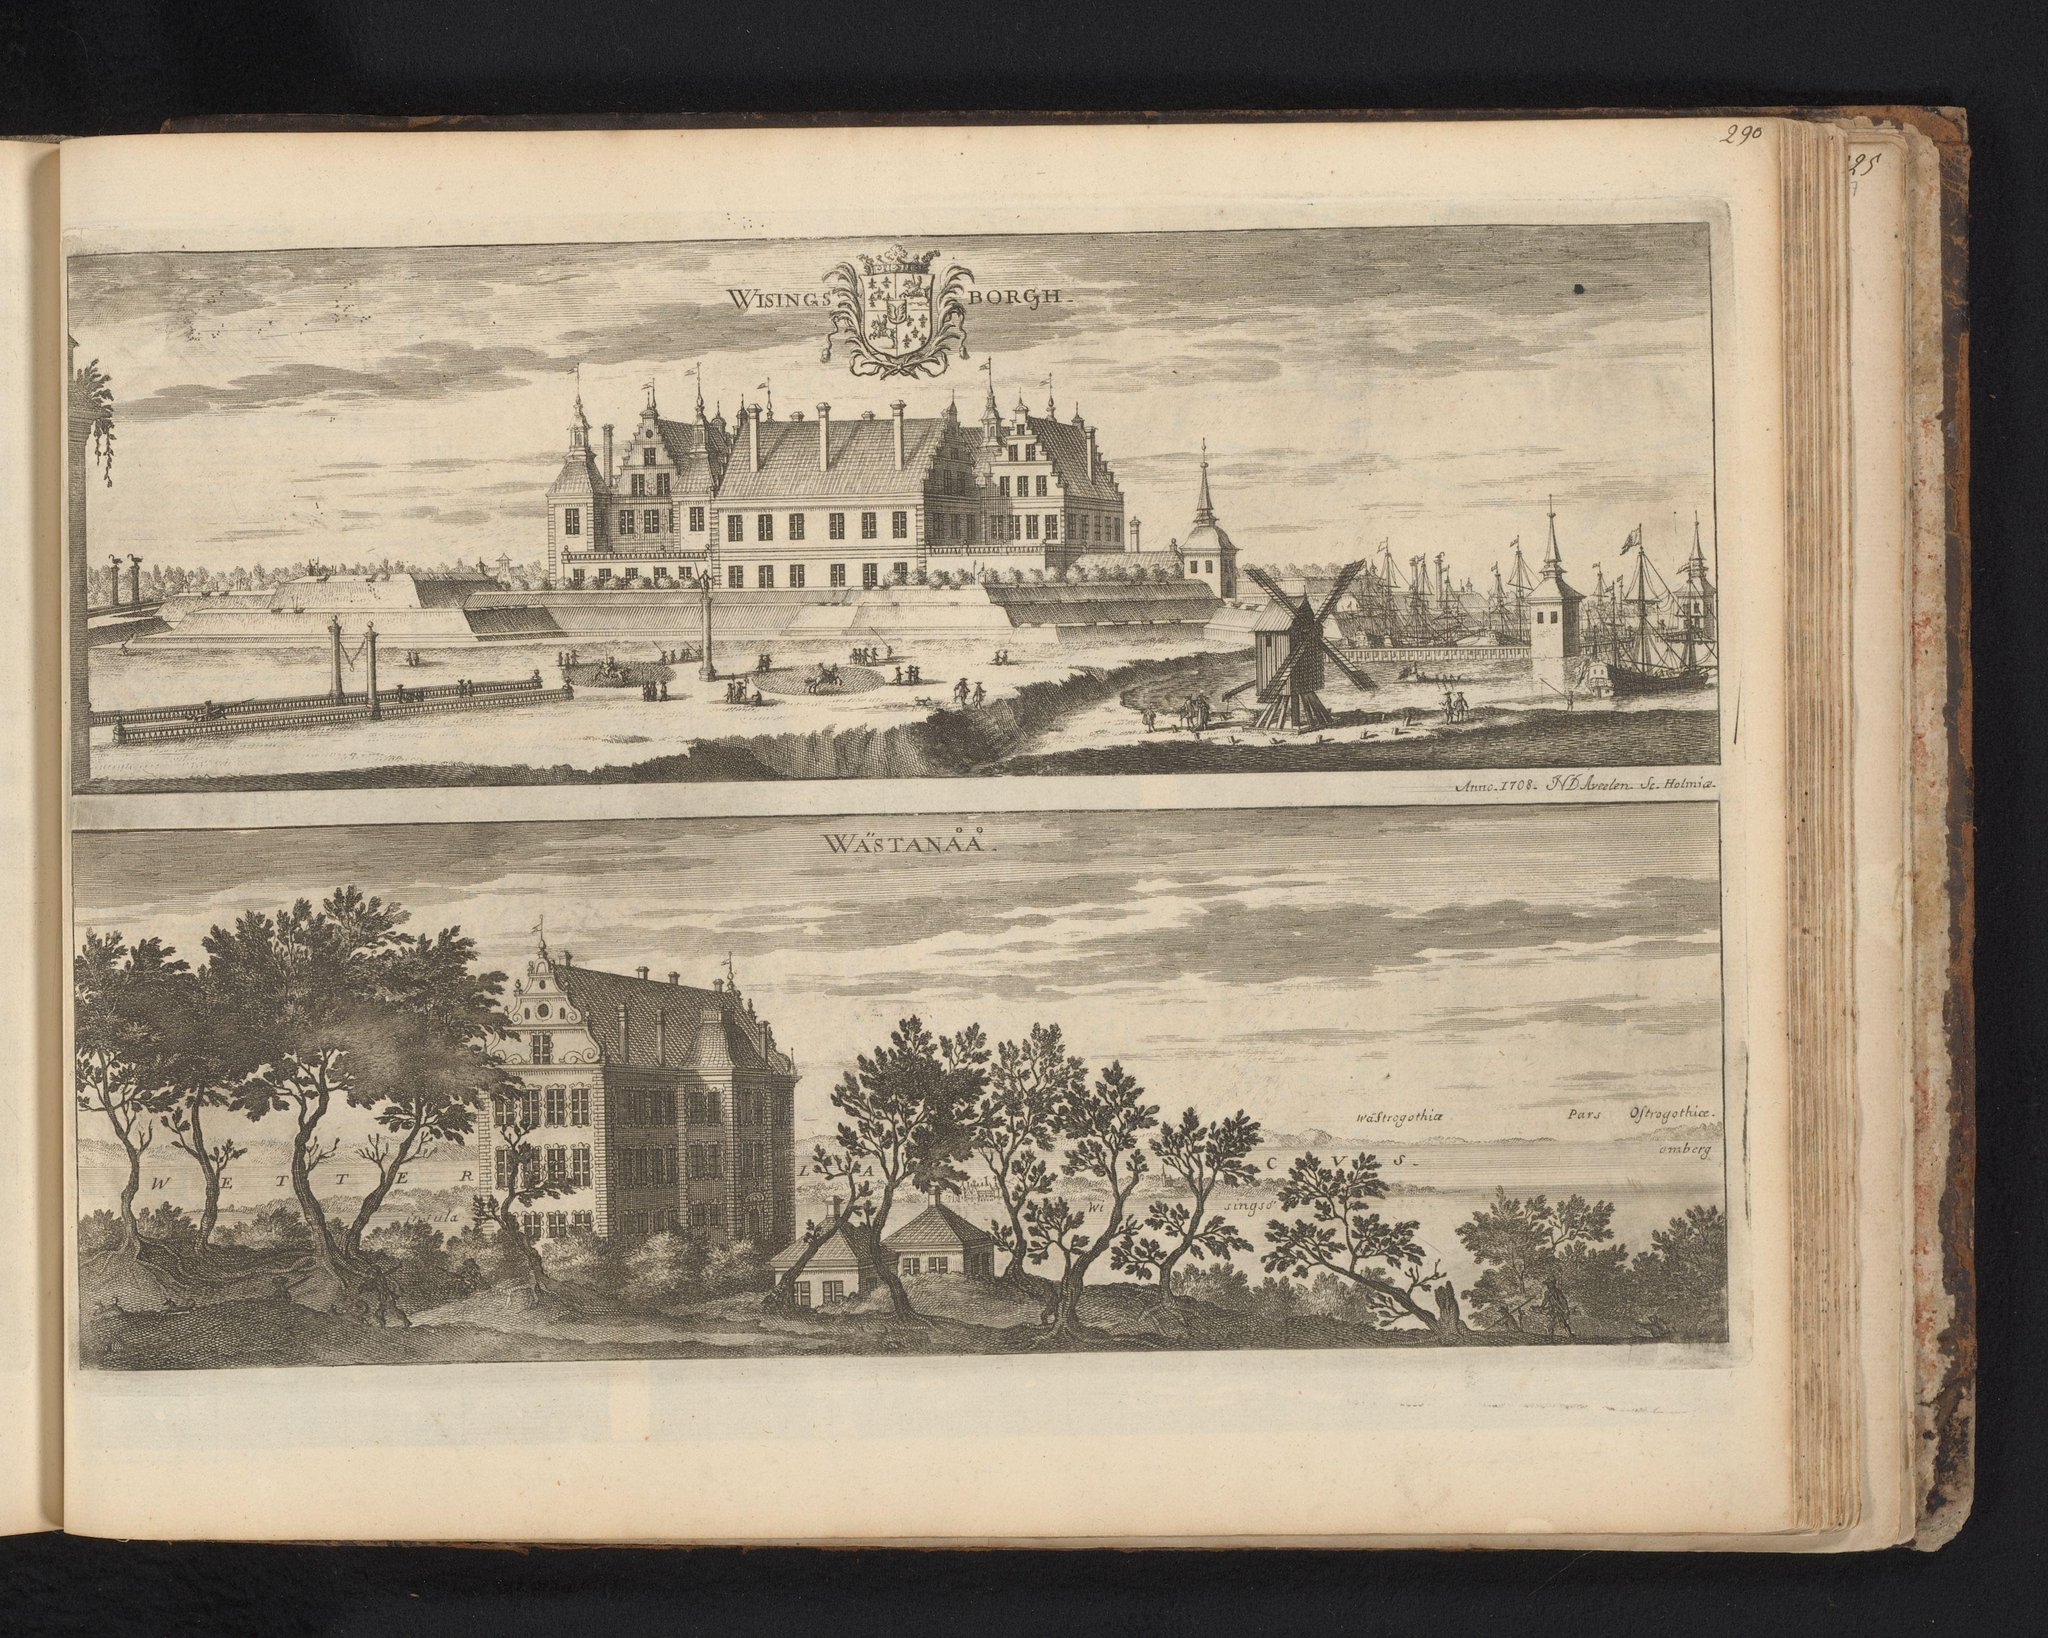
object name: print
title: Wisingsborgh / Wästanåå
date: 1708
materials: paper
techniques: etching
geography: stockholm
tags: city-view in general; 'veduta'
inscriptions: date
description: Kungliga Biblioteket, 'Suecia': http://www.kb.se/samlingarna/Kartor-bilder/Suecia-antiqua/ (geraadpleegd november 2016).